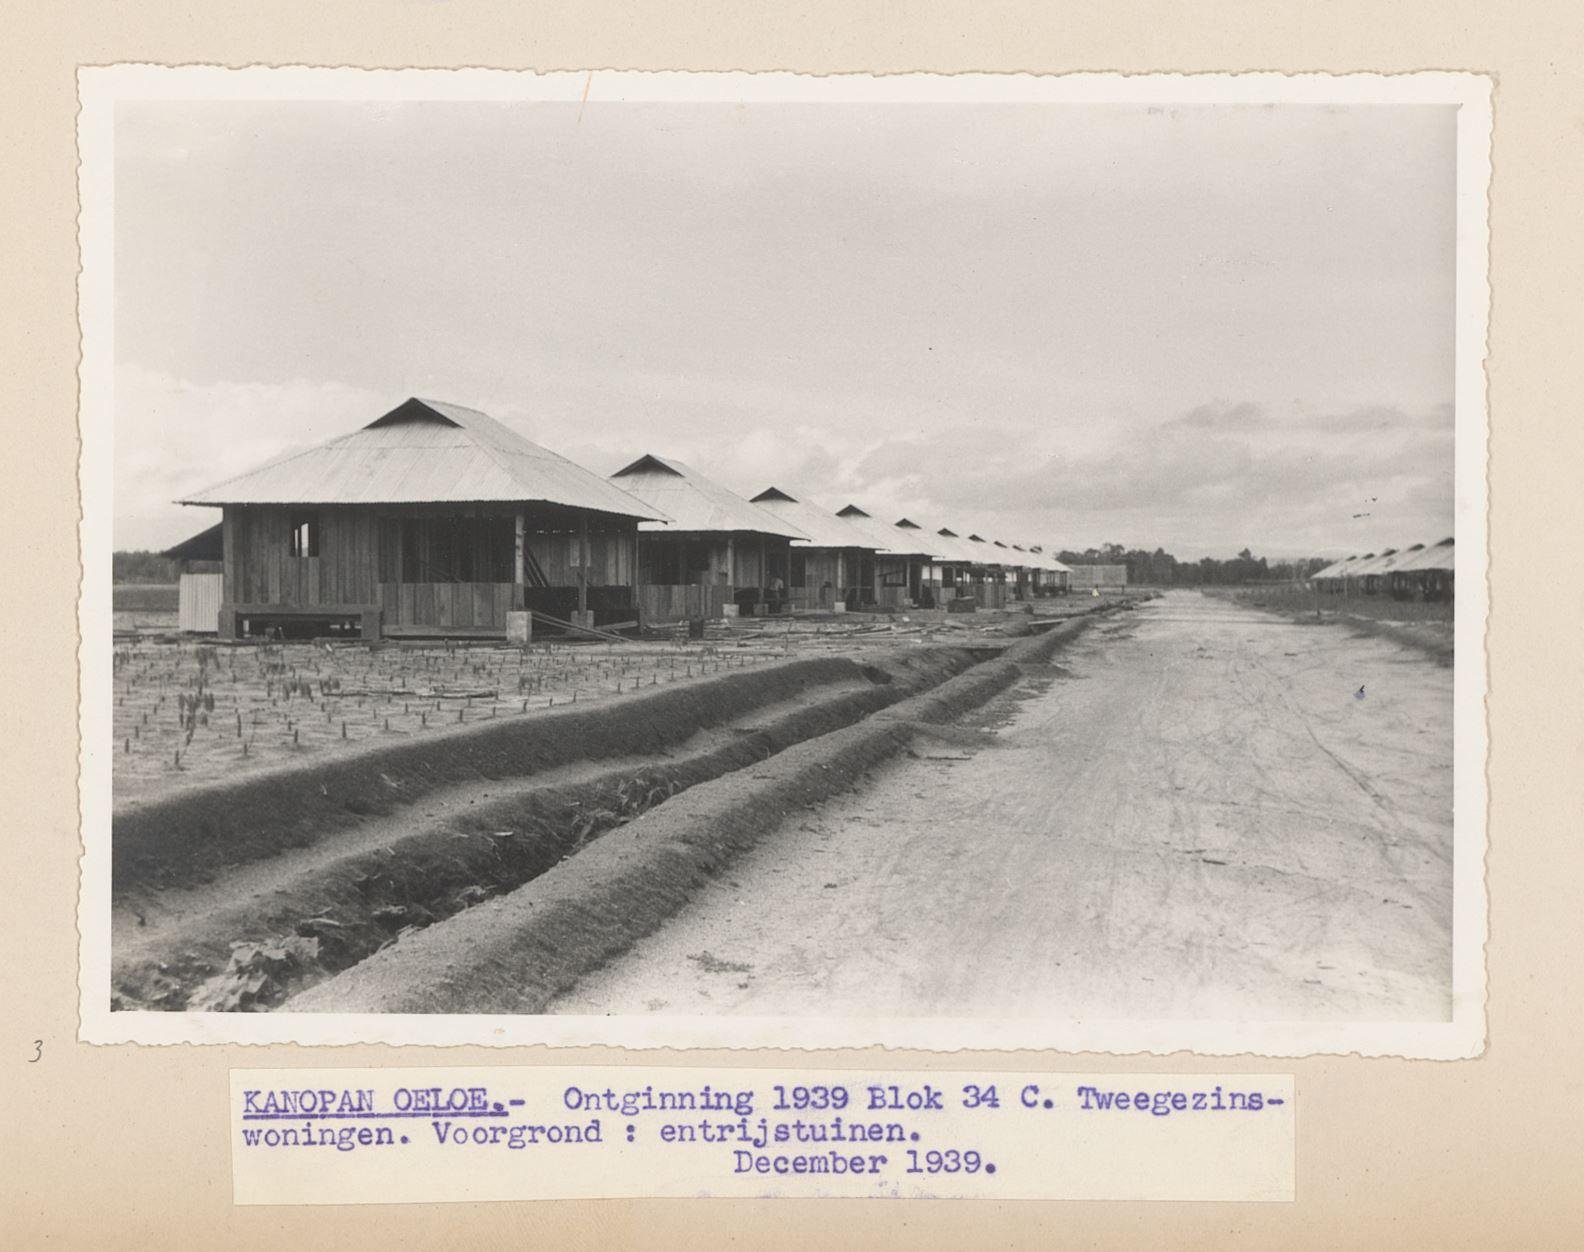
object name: photograph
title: Kanopan Oeloe - Ontginning 1939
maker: Anonymous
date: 1912-1939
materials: photographic support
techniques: gelatin silver print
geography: sumatra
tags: plantation, (non-fruit) products of plants or trees: rubber, rural housing, e.g. country-house, villa, cottage, sumatra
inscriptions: inscription: ‘Kanopan Oeloe - Ontginning 1939. Blok 34 C. Tweegezinswoningen. Voorgrond: entrijstuinen. December 1939.’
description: Ontginning in 1939: de nieuwe kolonisatiewoningen. Onderdeel van het fotoalbum over de plantages Leidong West en Kanopan Oeloe van de Cultuur Maatschappij Leidong West op Sumatra in de jaren 1925-1939.